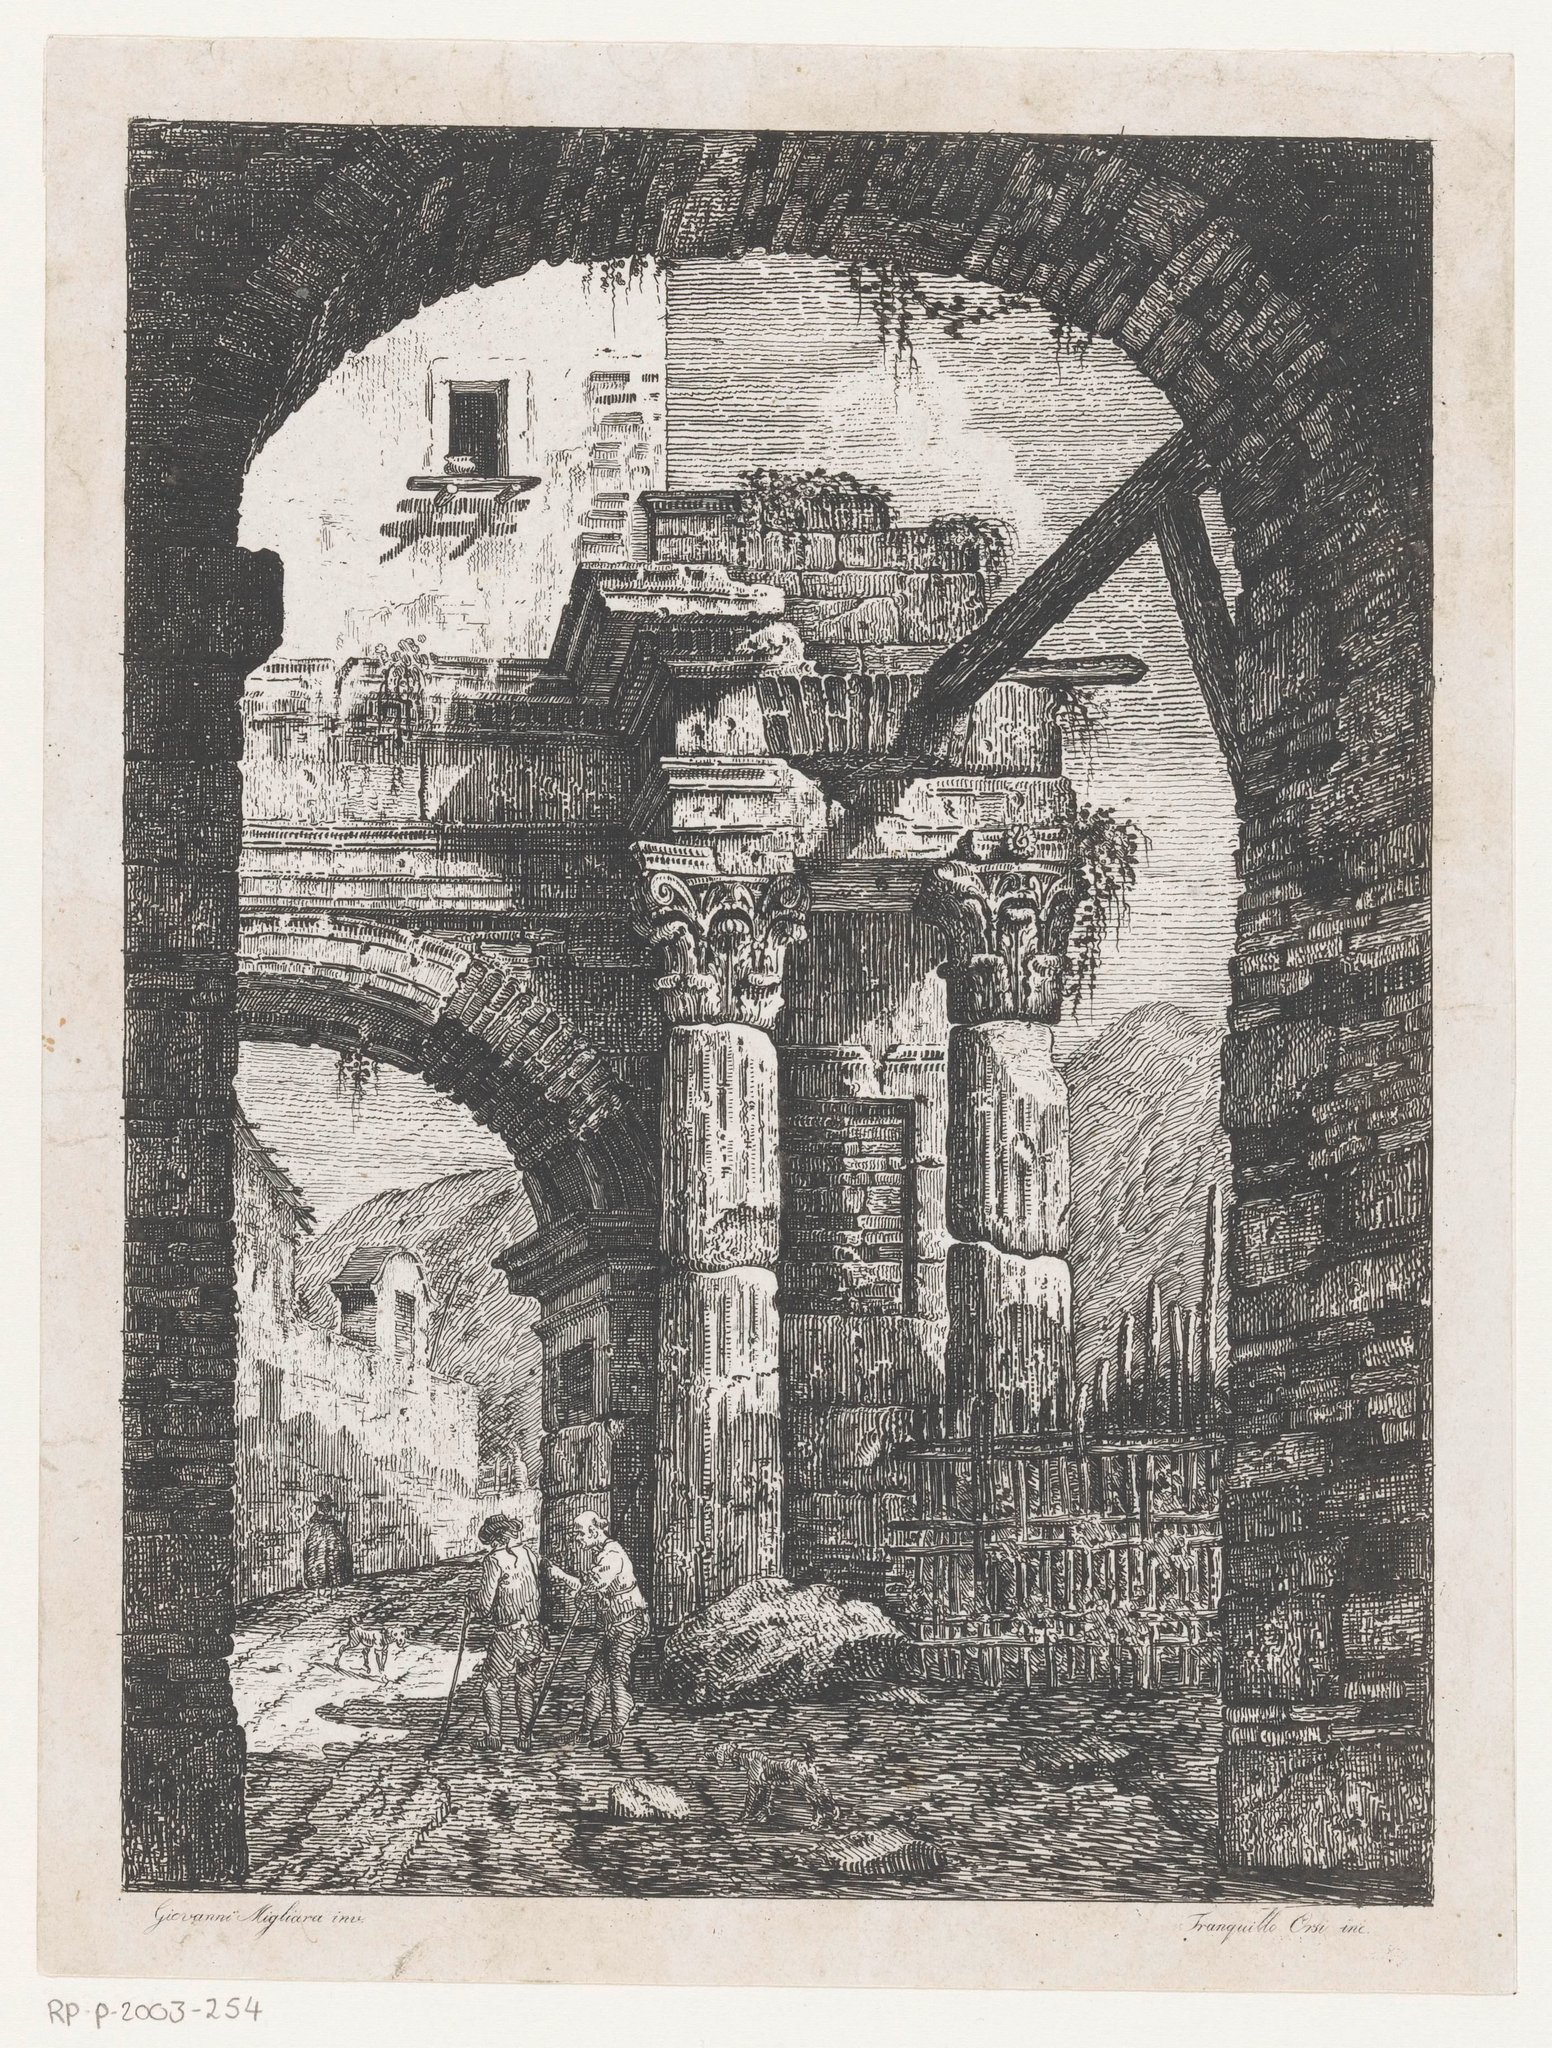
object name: print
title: Antieke ruïnes en wandelaars op een pad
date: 1795-1845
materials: paper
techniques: etching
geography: italy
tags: landscape with ruins, 'en route', traveller under way, corinthian order ~ architecture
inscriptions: collector's mark: Lugt 2228, collector's mark: Lugt 2760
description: Ruïne van een antieke poort met Korinthische zuilen. Op het pad dat onder de poort doorloopt twee wandelaars met twee honden. Op de achtergrond een bergachtig landschap. Het geheel wordt ingekaderd door een tweede poort op de voorgrond.